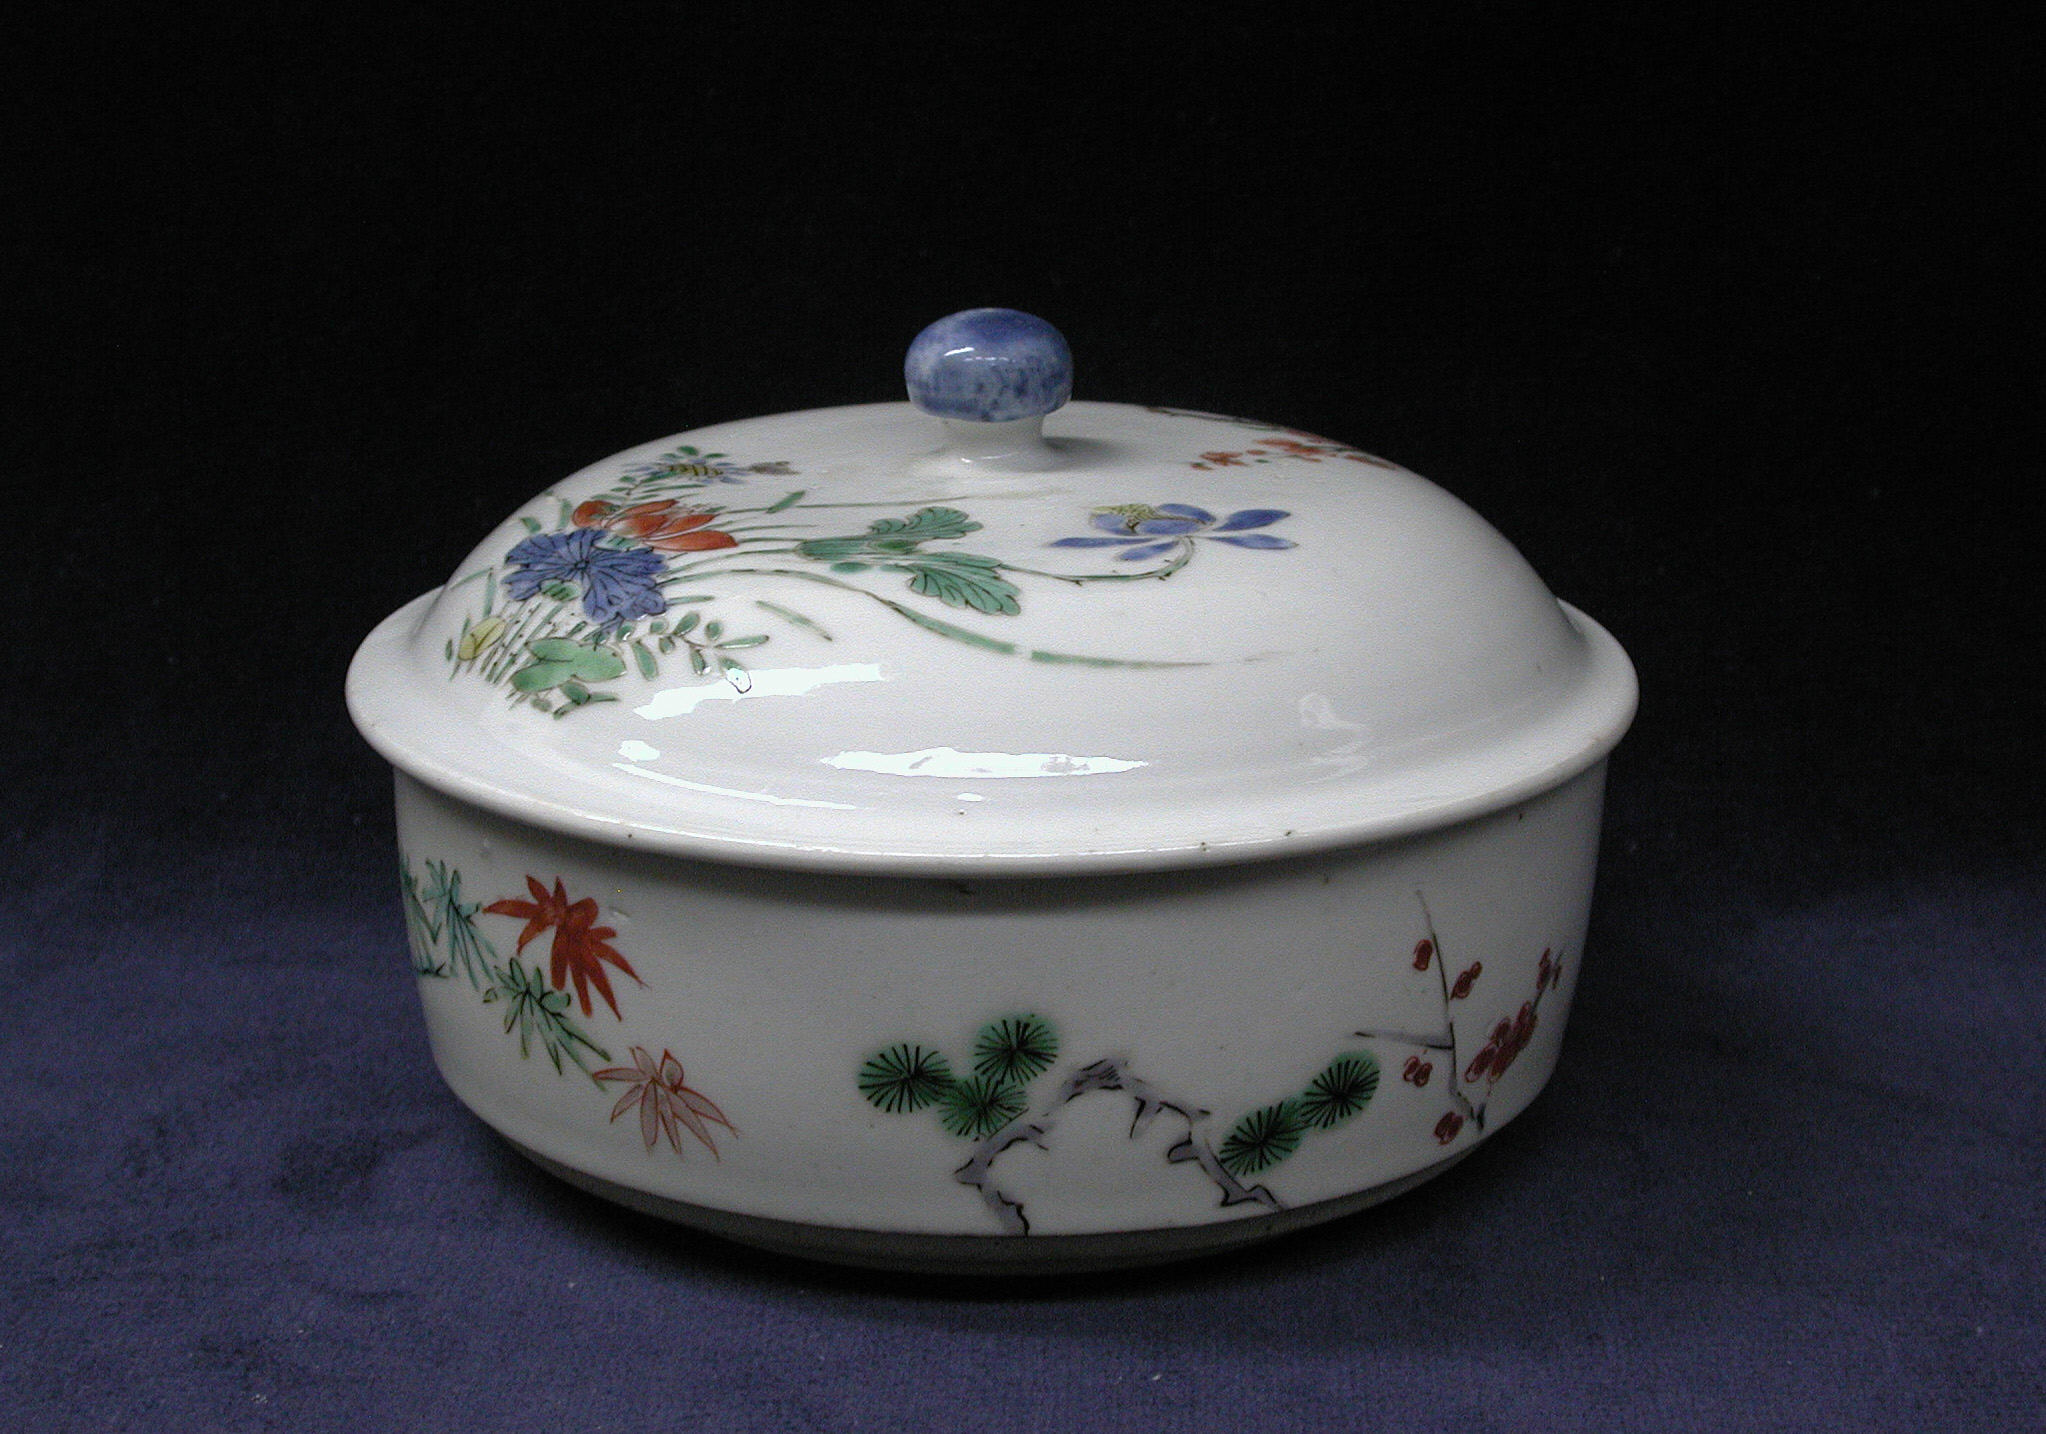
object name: bowl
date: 1701-1800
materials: hard paste porcelain